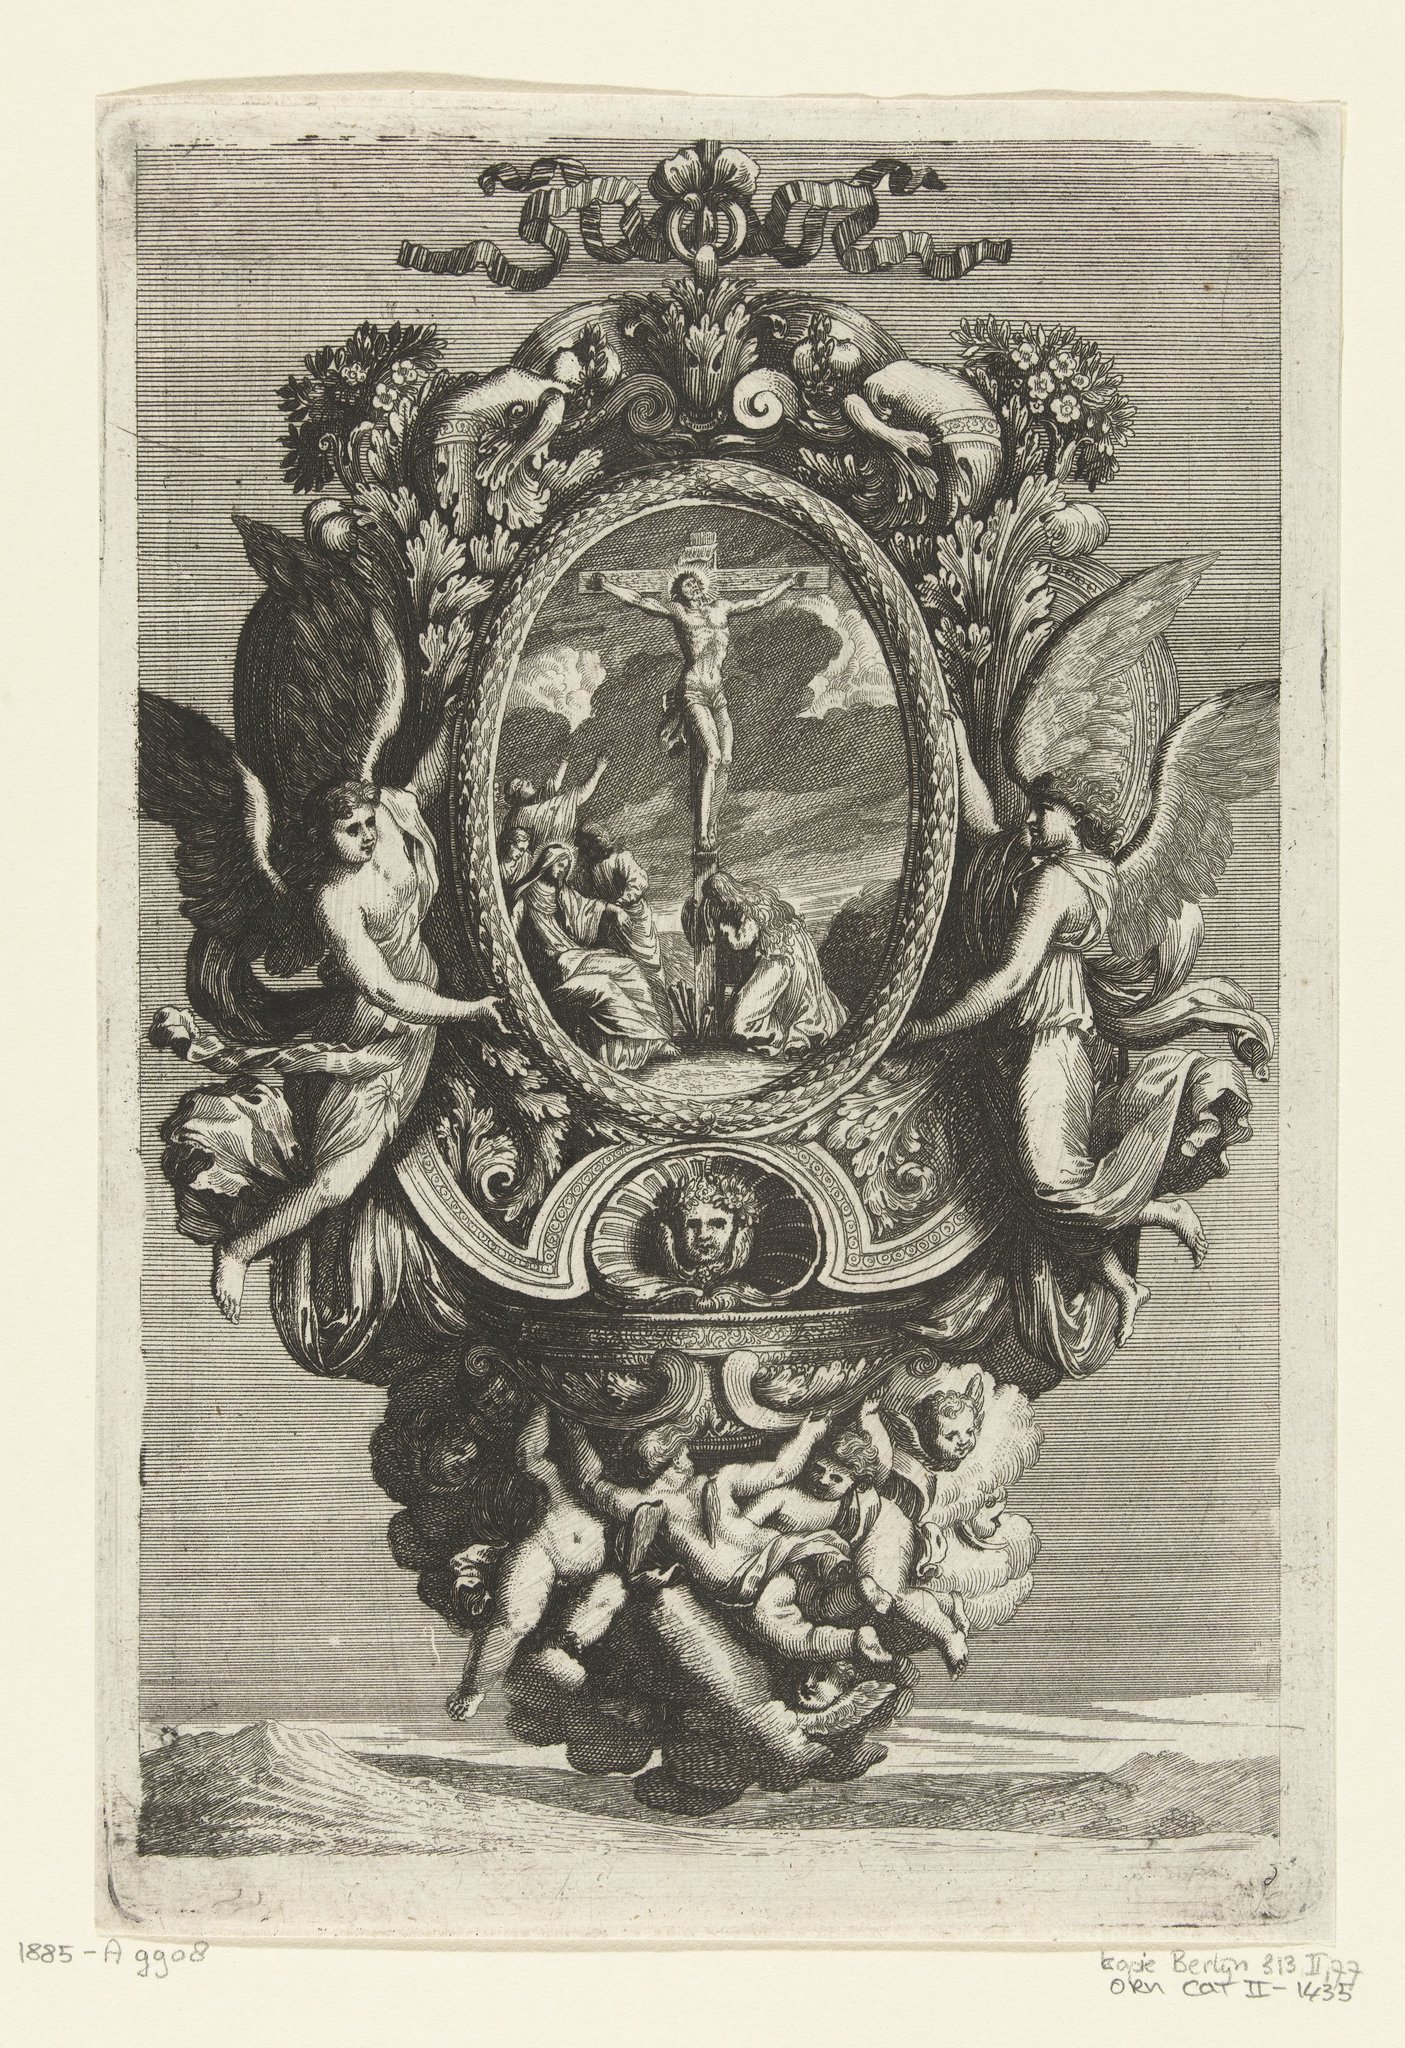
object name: ornament print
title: Varie inventioni di vasi da acqua benedetta fatti al moderno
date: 1677-1692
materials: paper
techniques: etching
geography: antwerp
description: De wijwaterbak wordt ondersteund door drie putti en zes cherubijnen. De achterplaat wordt gevormd door een ovaal medaillon, vastgehouden door twee engelen, met Christus aan het kruis.